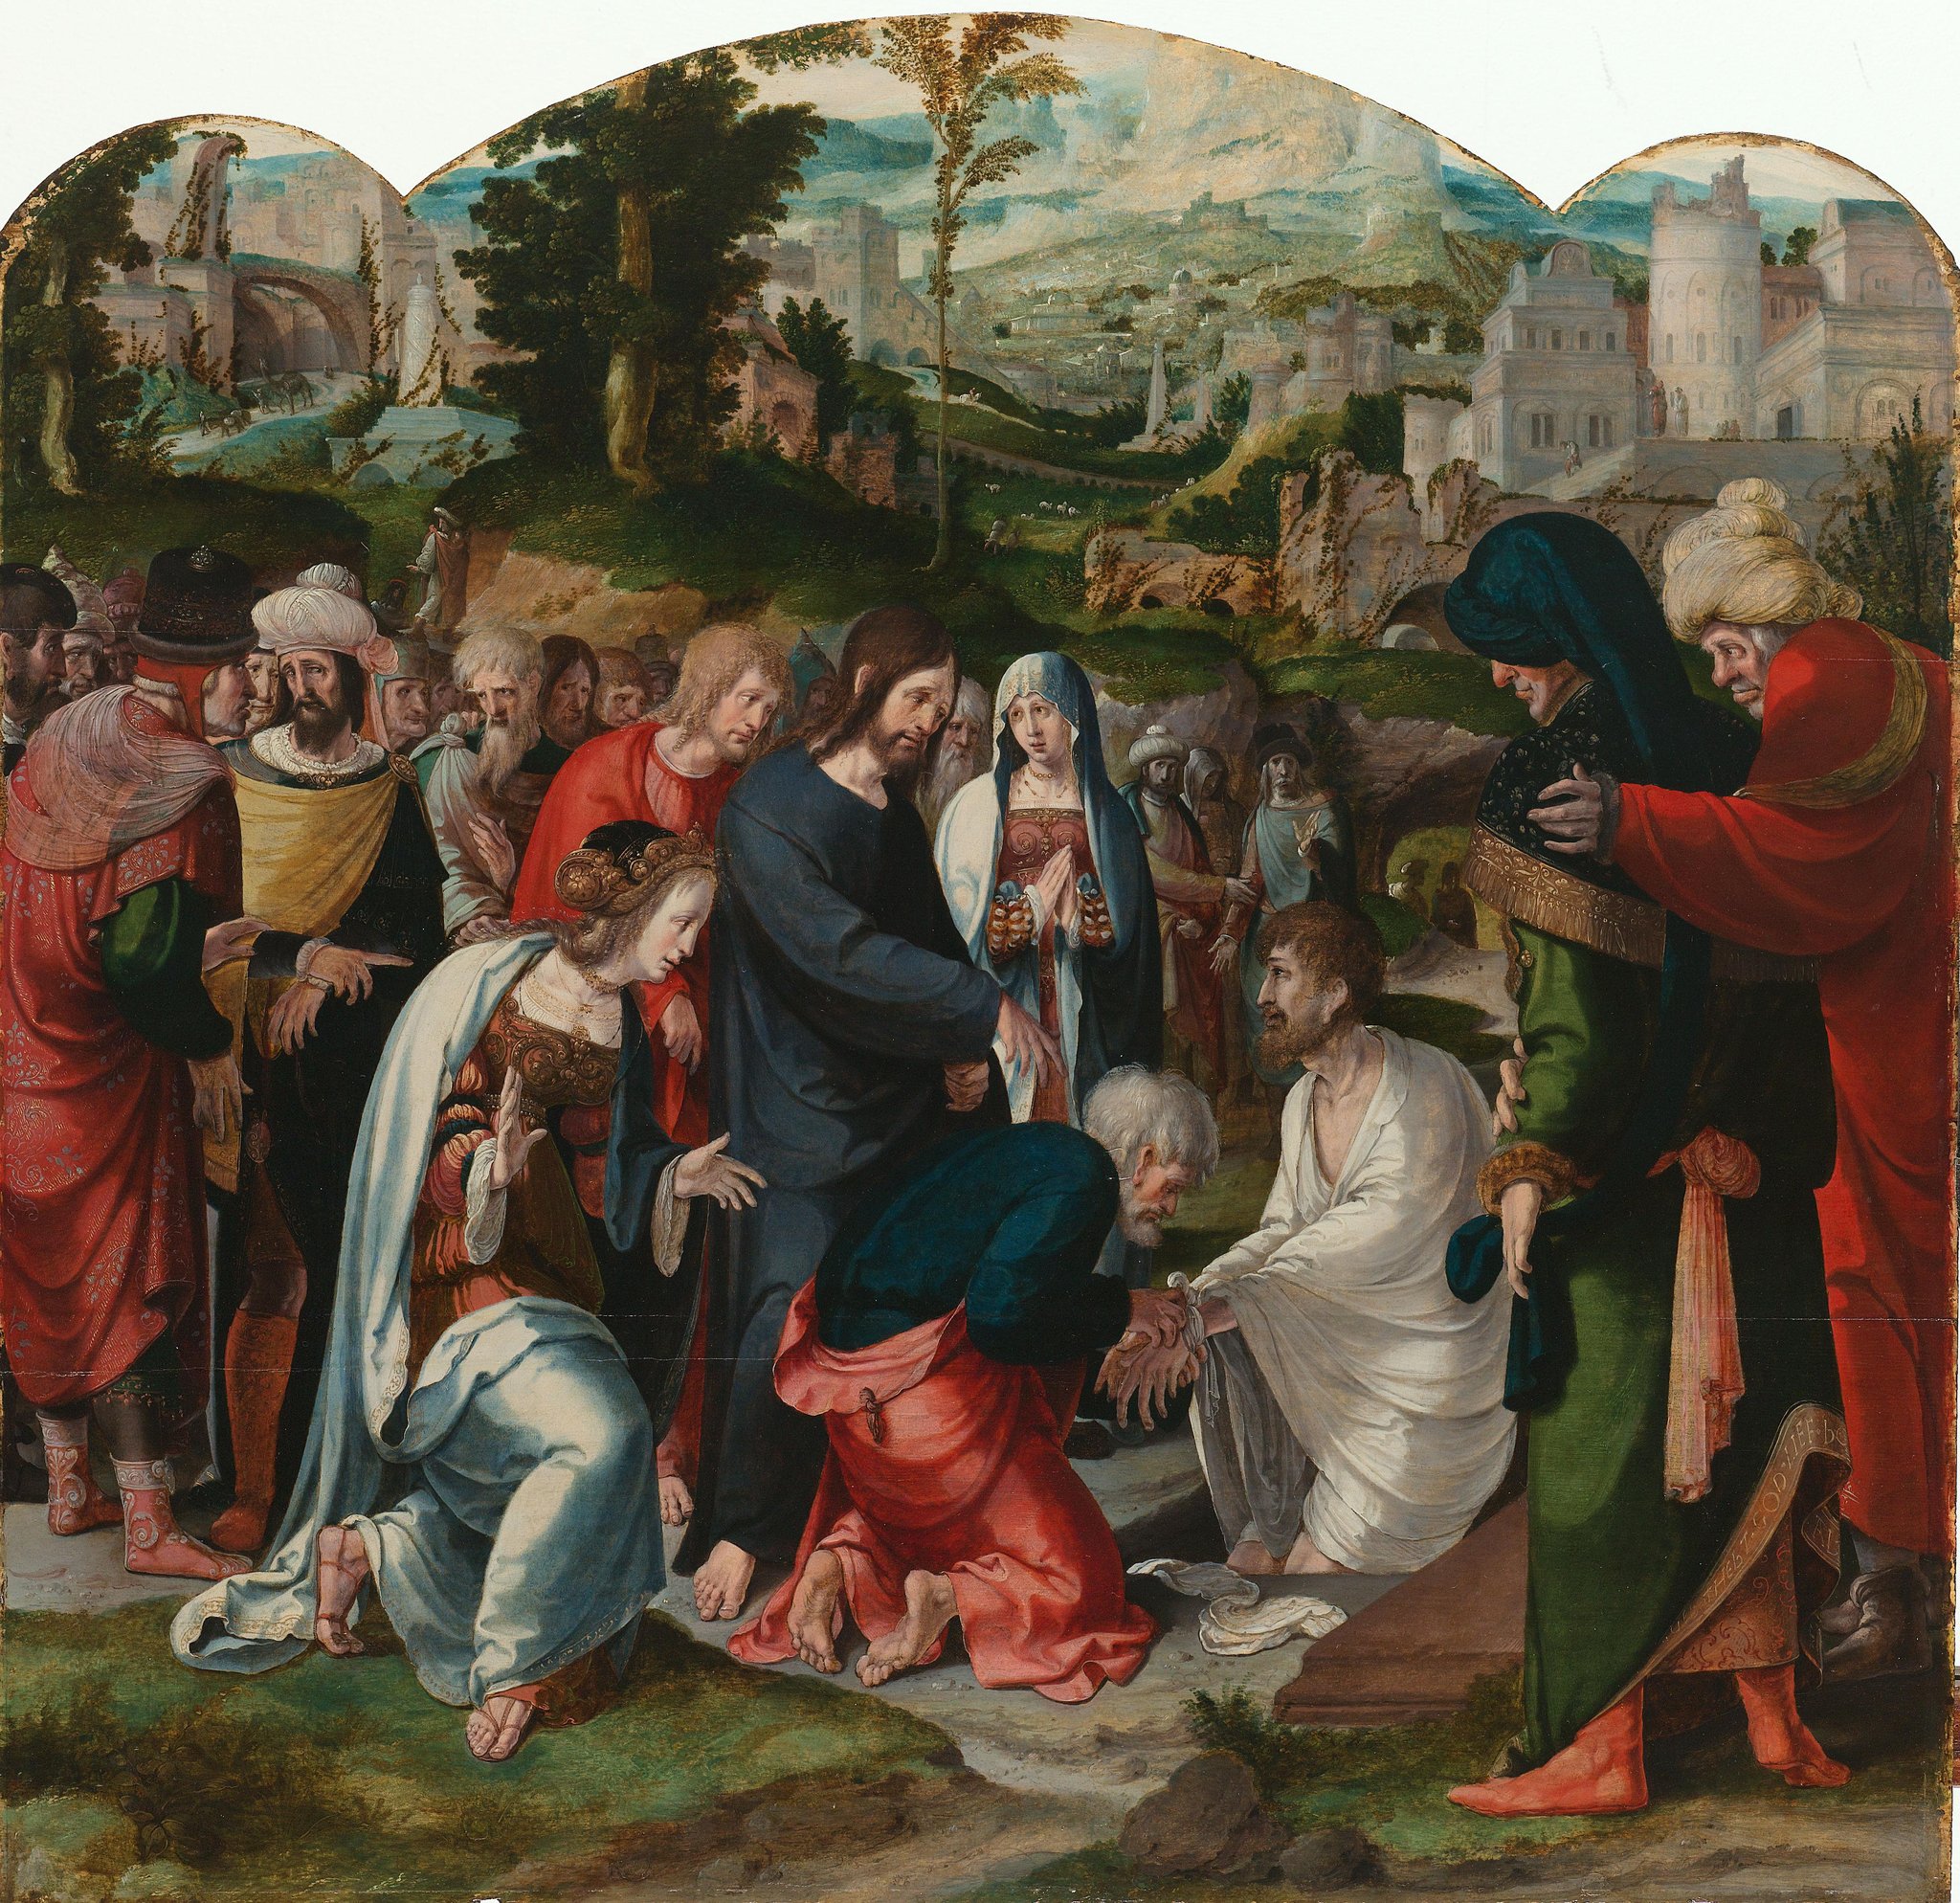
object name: triptych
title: The Raising of Lazarus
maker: aertgen claesz van leyden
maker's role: draughtsman, painter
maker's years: 1498-1564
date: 1530-1535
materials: oil, panel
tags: lazarus' shroud is removed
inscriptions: inscription, lower right, on the seam of the robe of the second figure: ‘GEBOD.HEBT.GOD.LIEF.BOven.AL.Ende’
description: This triptych was painted to commemorate a married couple, the man and woman shown kneeling on the wings. The central panel appropriately depicts the miracle of Christ raising Lazarus from the dead, an allusion to the promise of eternal life and the belief that death is overcome through faith in Christ.